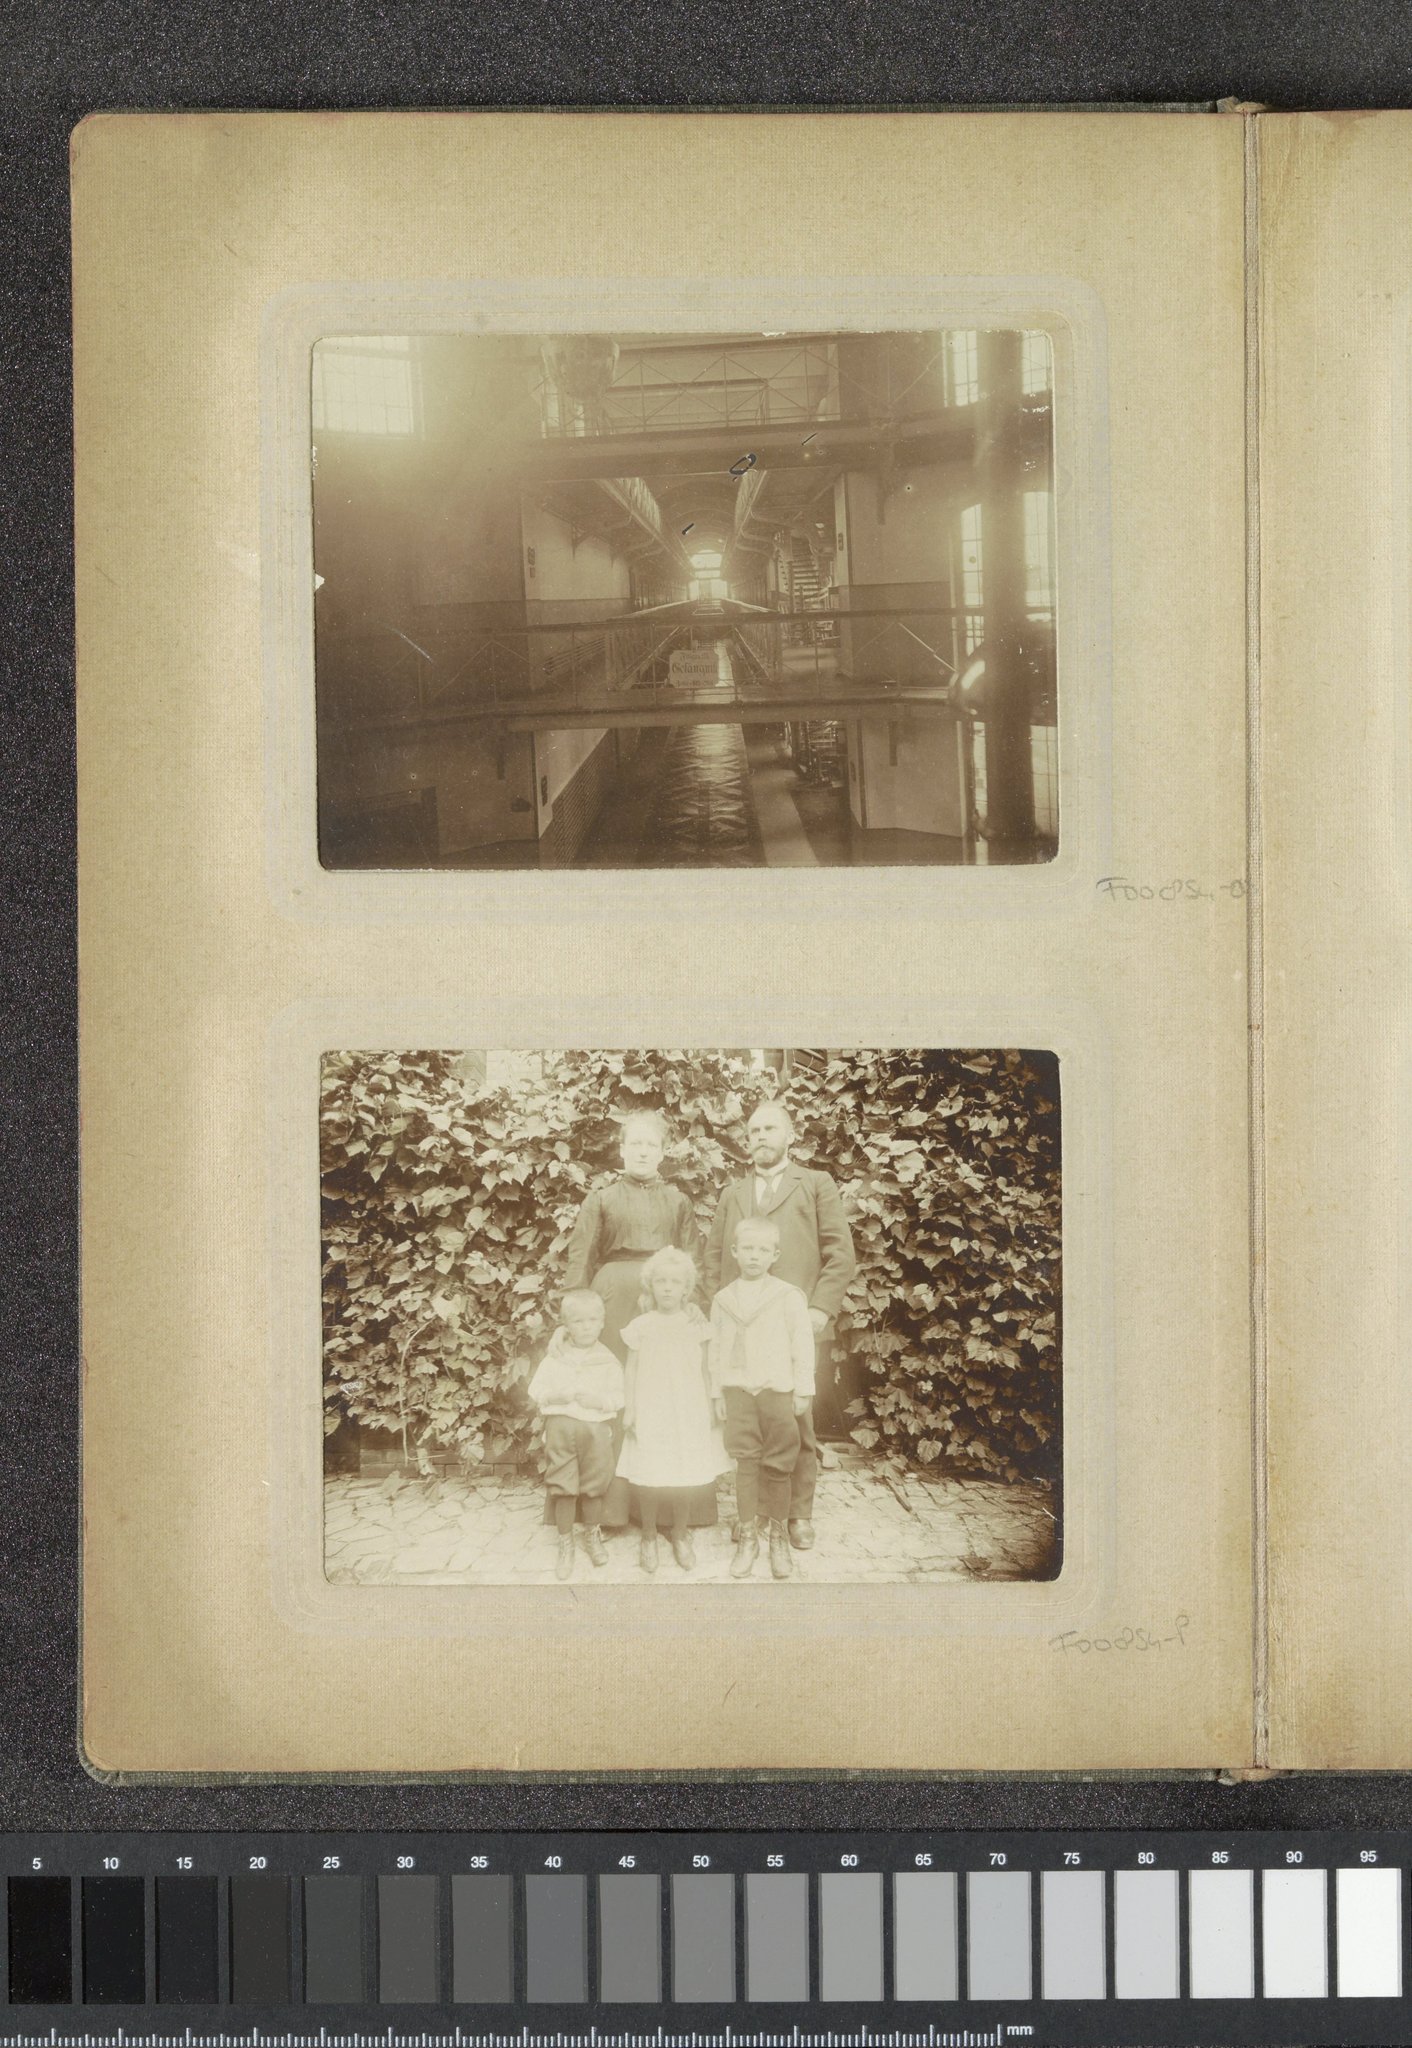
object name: photograph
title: Interieur van de gevangenis van Oslebshausen met gang en loopbruggen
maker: Anonymous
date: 1890-1910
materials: cardboard, paper, photographic support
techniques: daylight paper print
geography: germany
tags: prison, jail, germany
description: Onderdeel van Fotoalbum van Carl Heinrich Fliegenschmidt, gevangenisdirecteur te Oslebshausen.